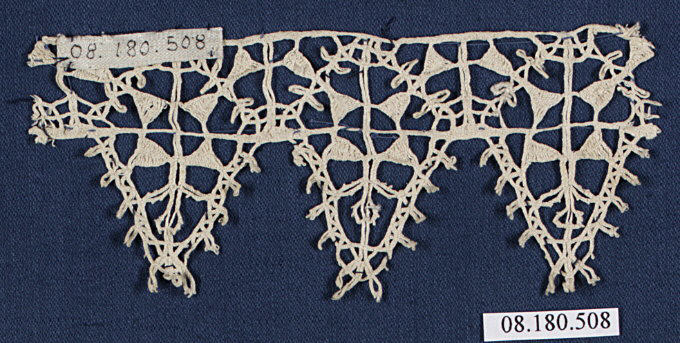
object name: fragment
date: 1501-1600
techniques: lace